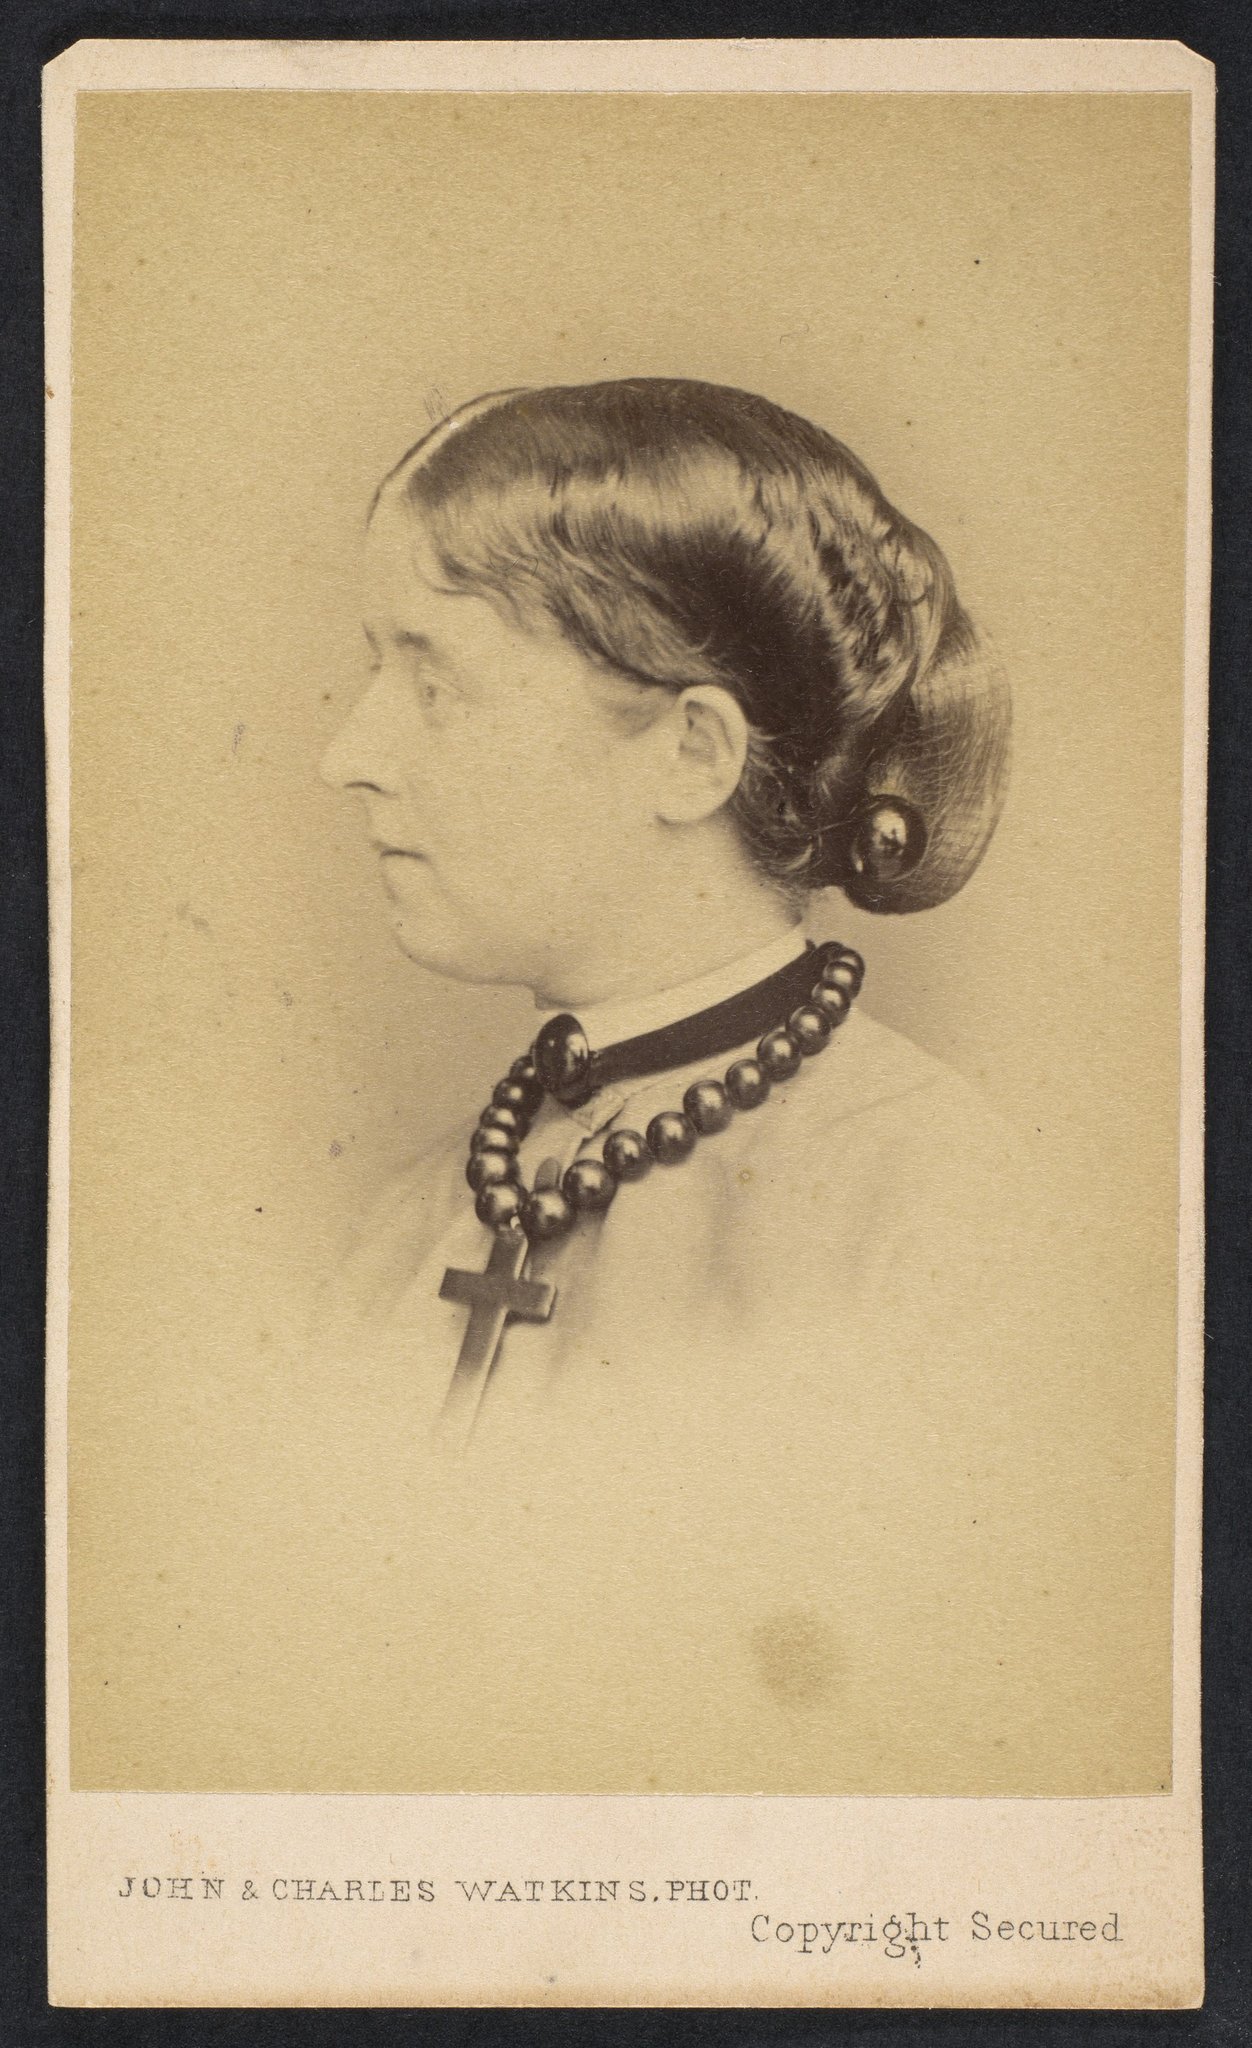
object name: carte de visite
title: [Adelaide Claxton]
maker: john and charles watkins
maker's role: photography studio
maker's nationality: british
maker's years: 1840-1875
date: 1860-1869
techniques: albumen silver print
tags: portraits,profiles,women